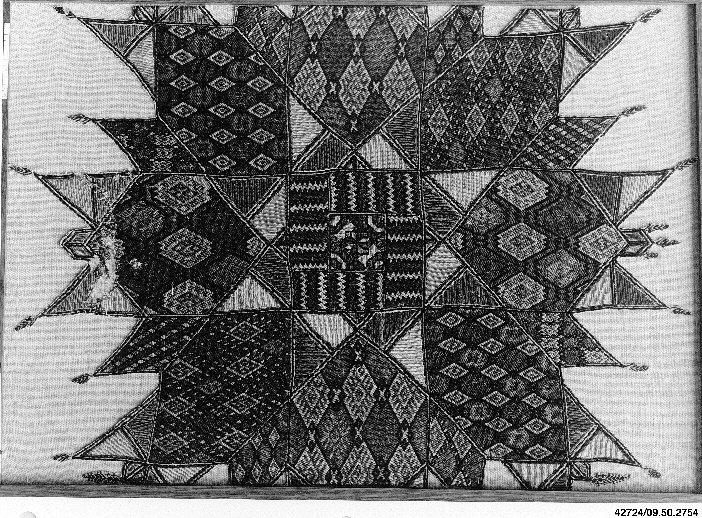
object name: chair cover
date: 1801-1900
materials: silk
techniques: embroidery, weave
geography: morocco